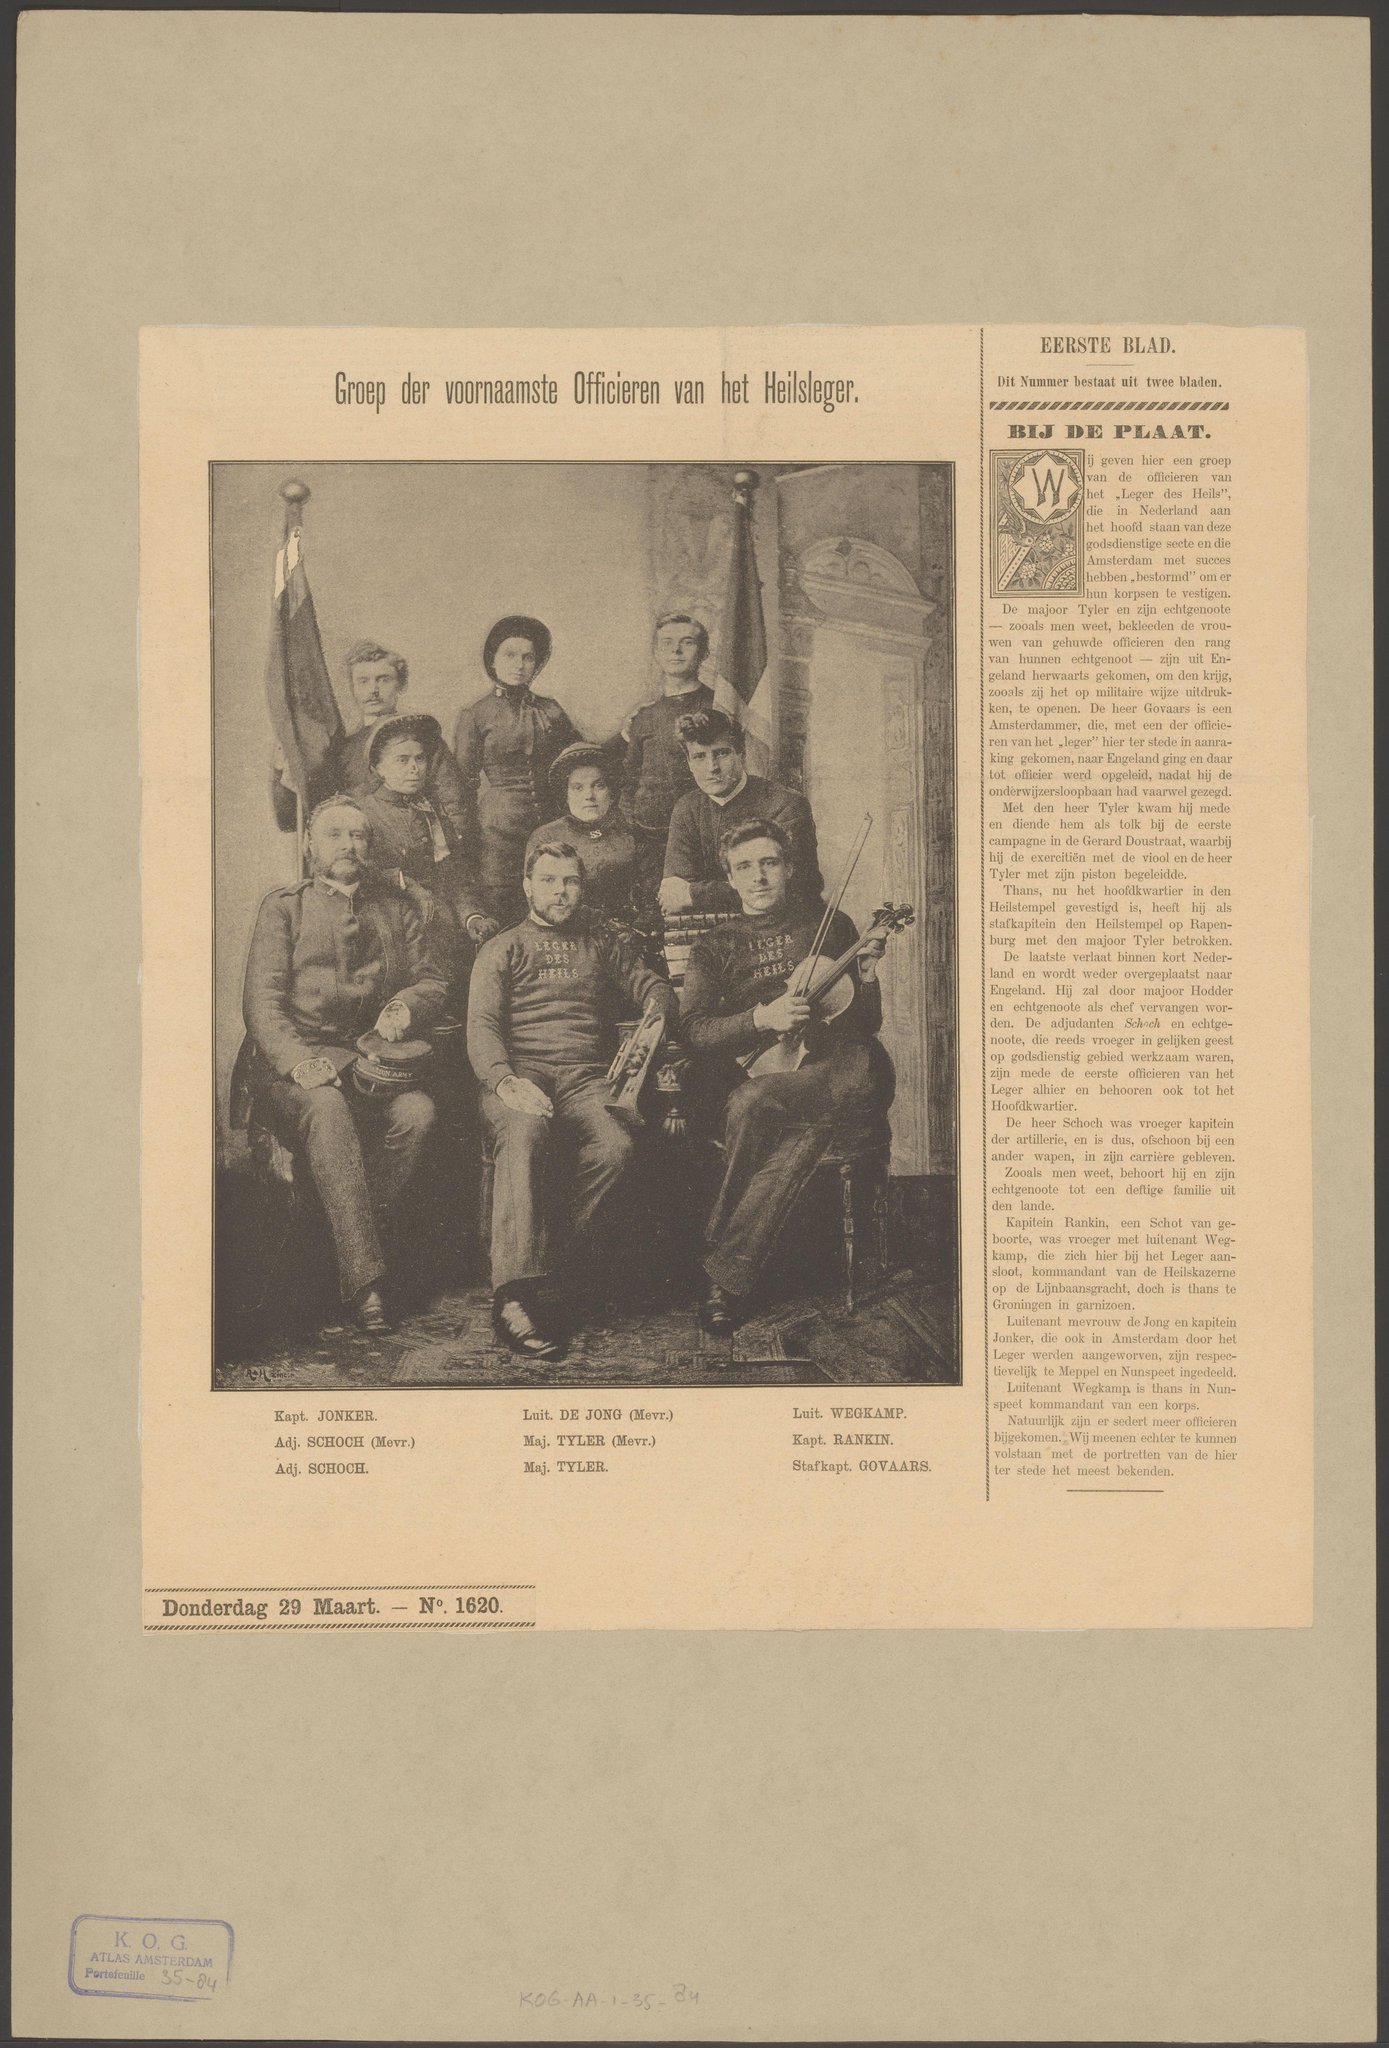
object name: photomechanical print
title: Groepsportret van officieren van het Leger des Heils te Amsterdam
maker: Anonymous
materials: paper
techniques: letterpress printing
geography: amsterdam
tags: assembly-room, salvation army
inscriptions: collector's mark: ‘35-84’ Lugt 1641b, signature: ‘R&H zinc;’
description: Onderwerpsrubriek binnen de Atlas Amsterdam: R.K. Gemeenten: Leger des Heils.